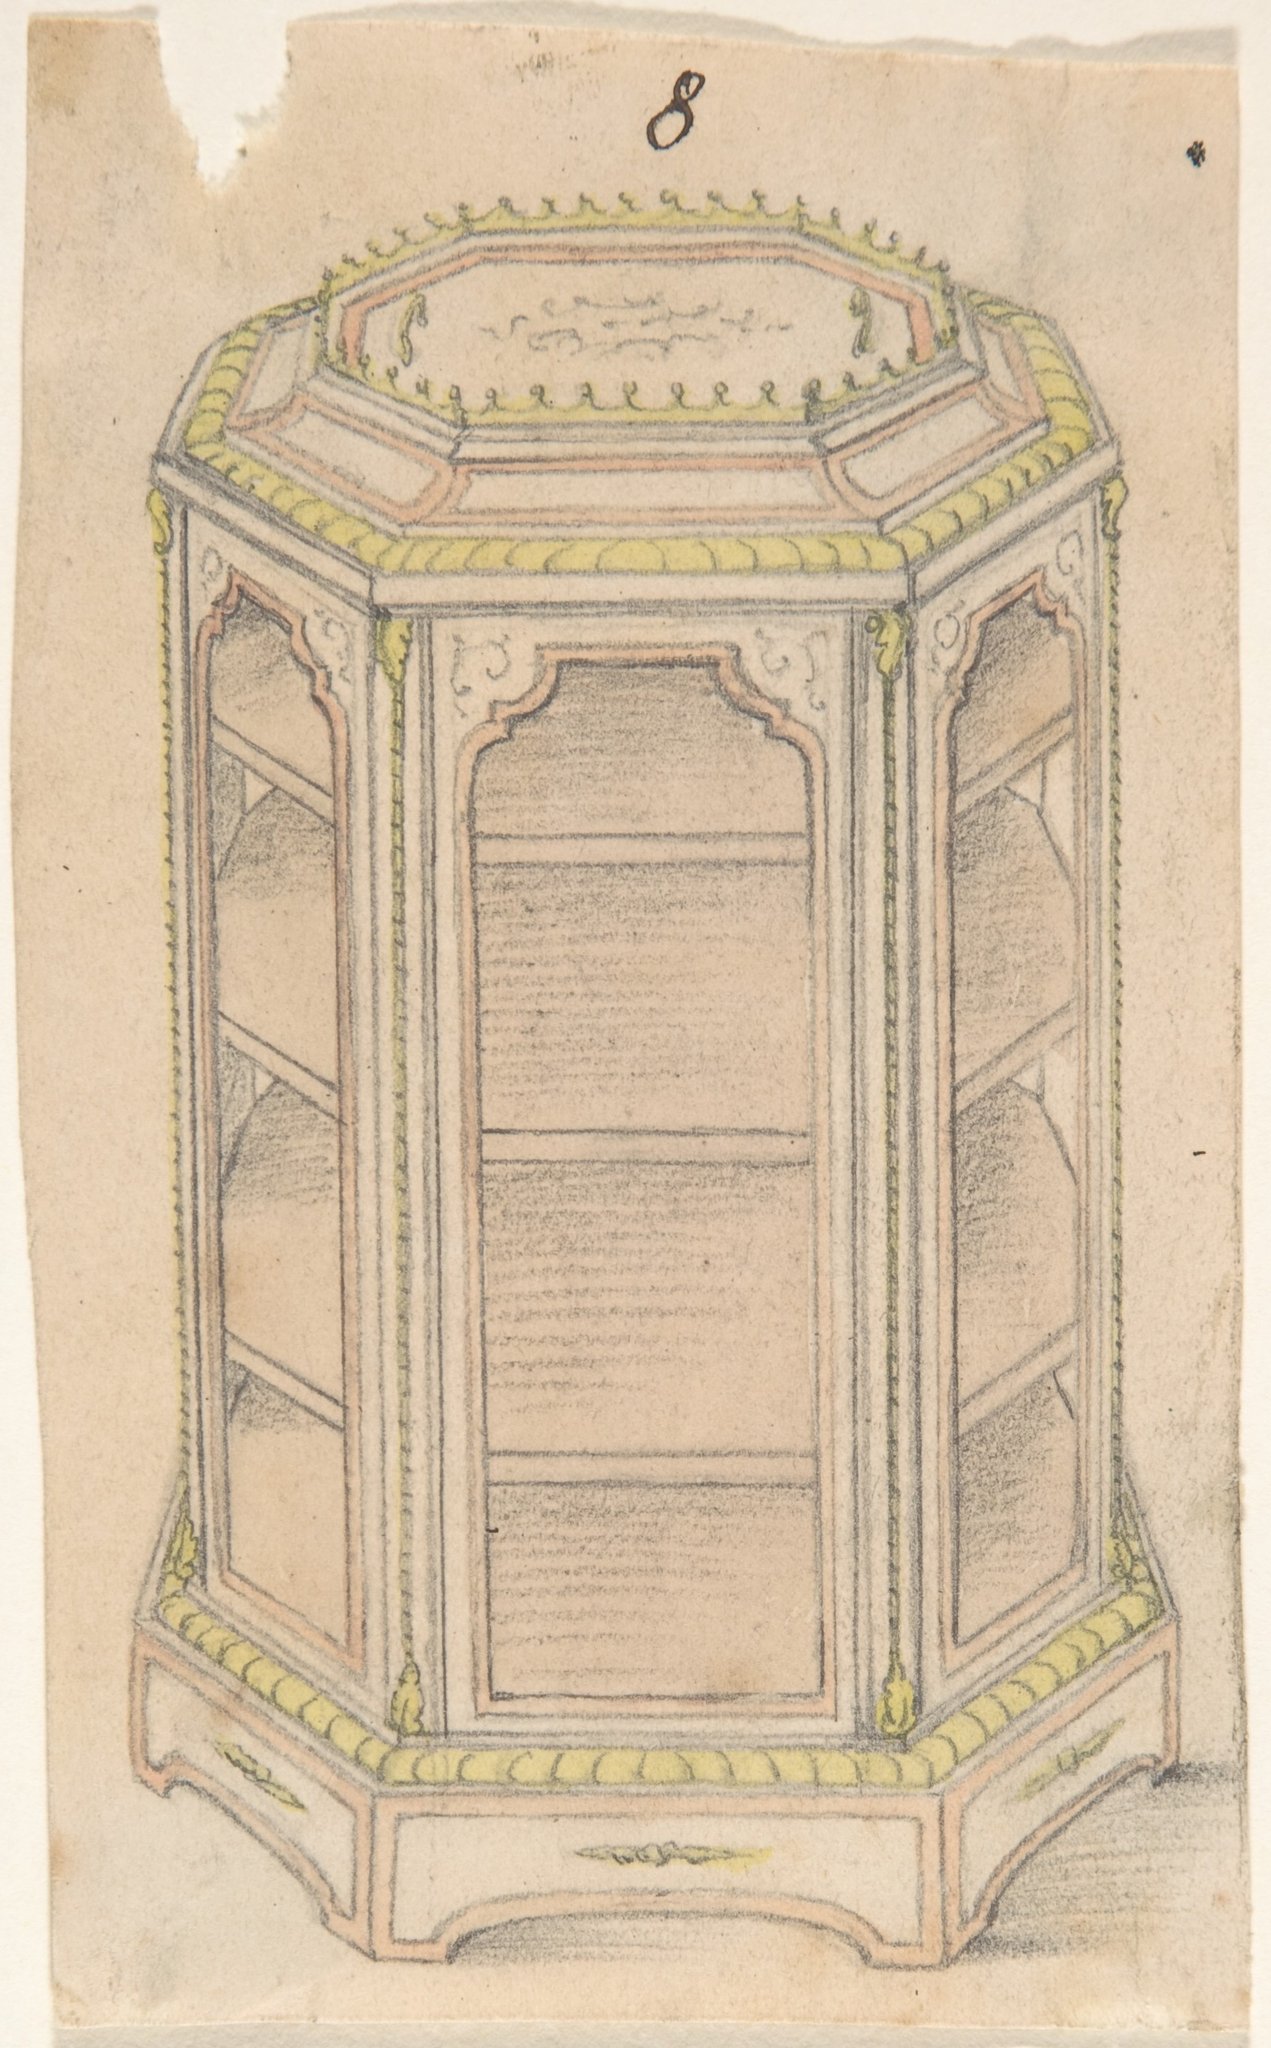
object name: drawing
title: Design for an Octagonal Cabinet with Glass Doors and Shelves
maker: anonymous, british, 19th century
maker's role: artist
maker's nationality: british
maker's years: 1800-1900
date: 1801-1900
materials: graphite, ink, watercolor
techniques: pen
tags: cabinets